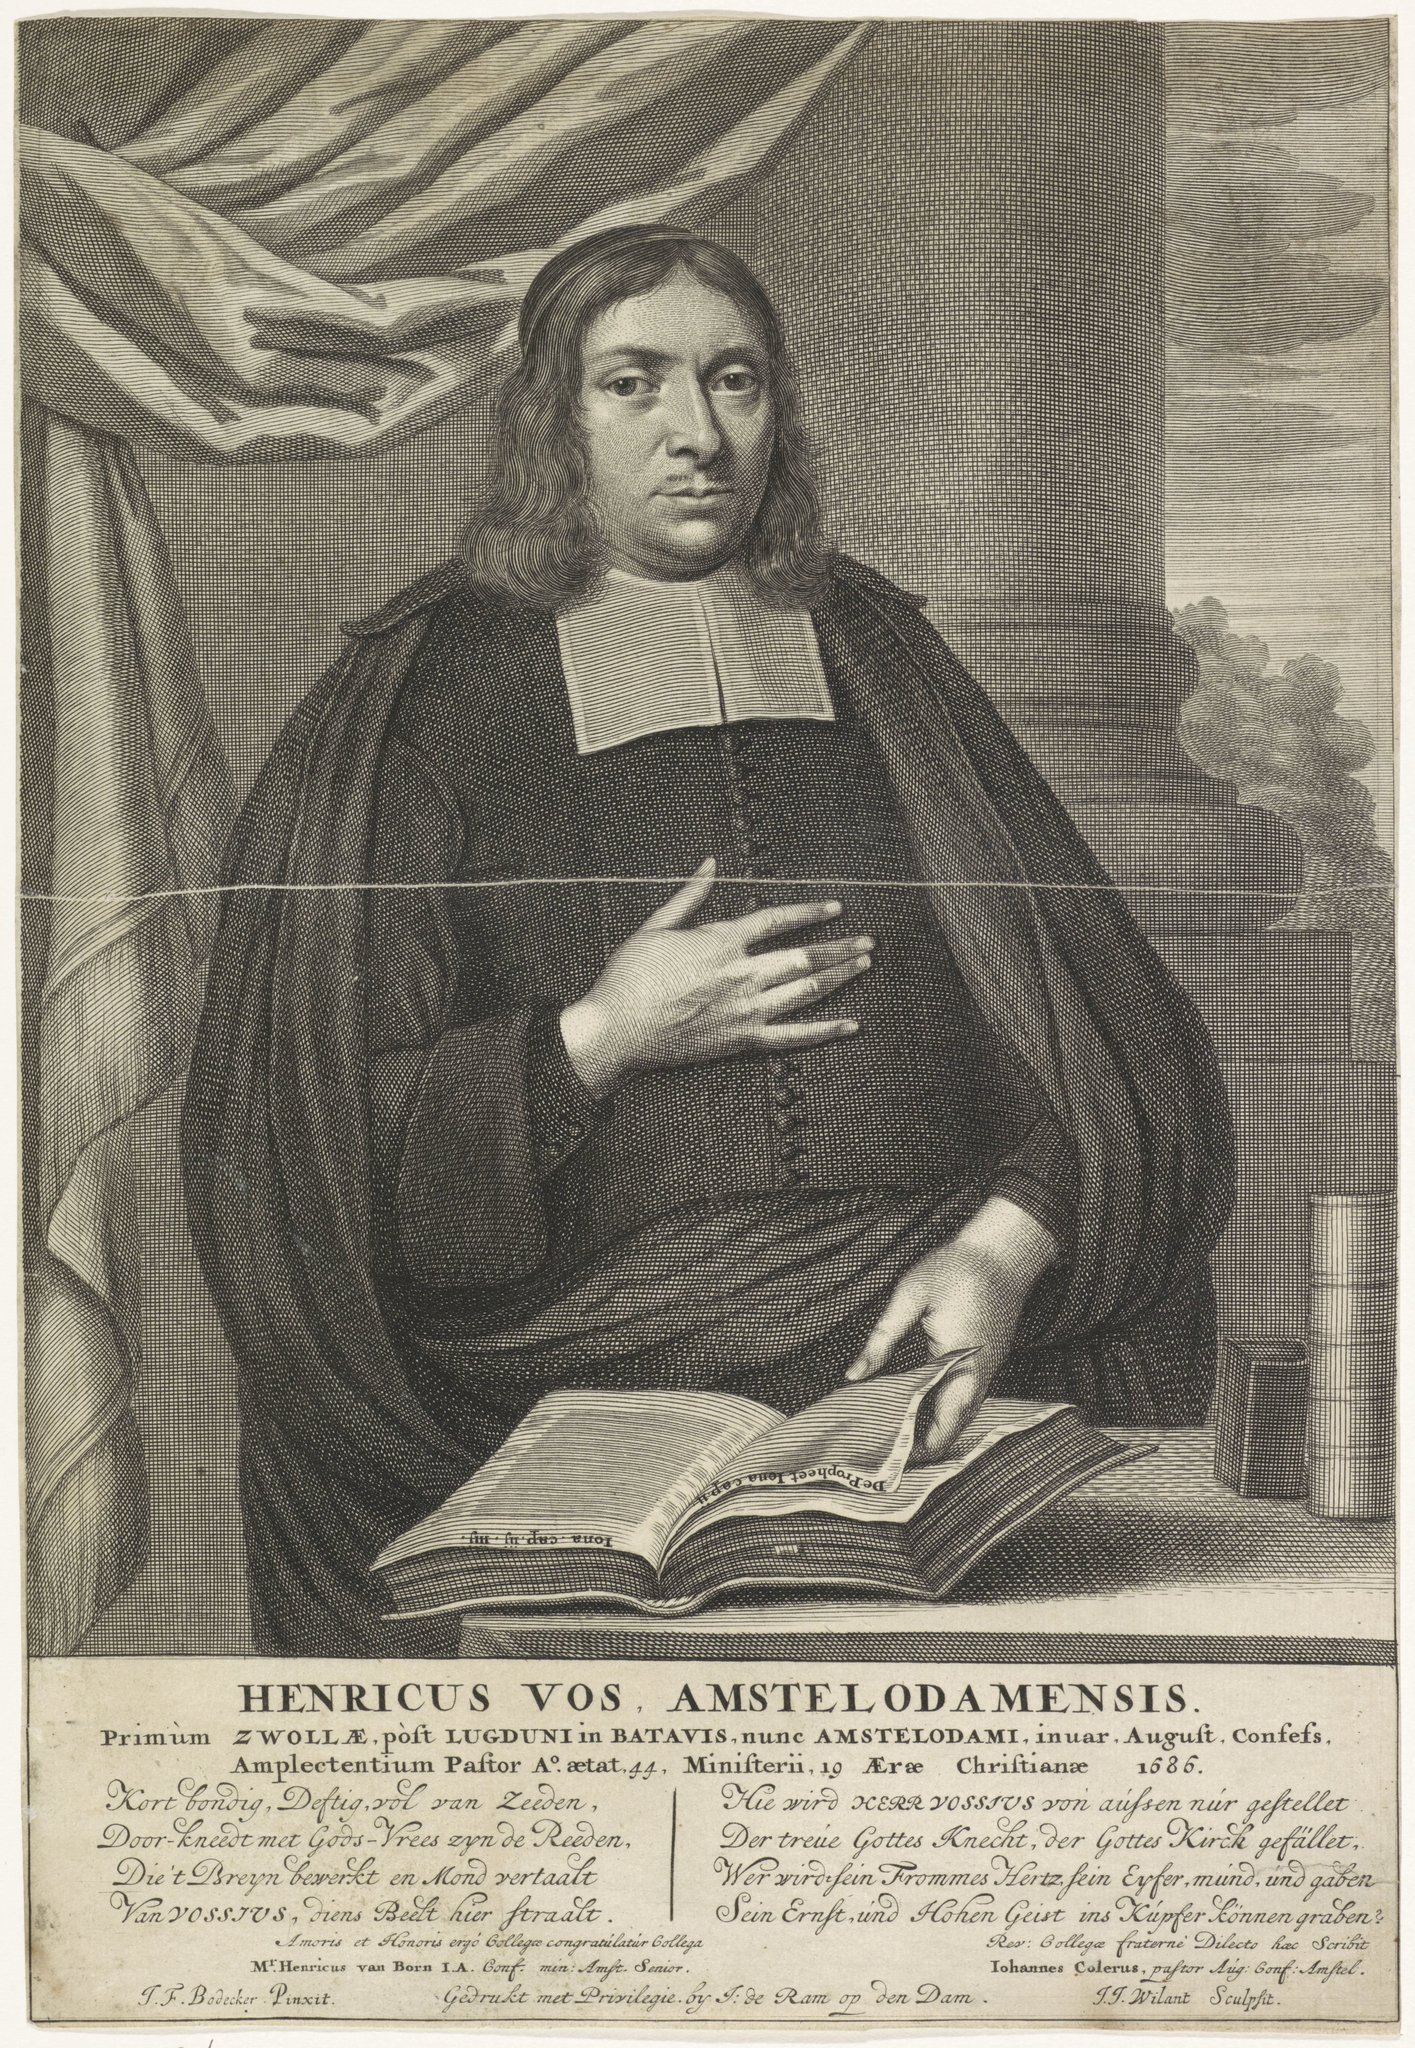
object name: print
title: Portret van de predikant Henricus Vos, op 44-jarige leeftijd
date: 1686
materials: paper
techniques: engraving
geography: amsterdam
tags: henricus vos, the bible as a book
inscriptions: collector's mark: Lugt 2228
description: Hij bladert door een Bijbel. In de marge de naam van de geportretteerde, en twee regels met biografische gegevens in het Latijn. Daaronder een vierregelig lofdicht in het Nederlands en in het Duits.